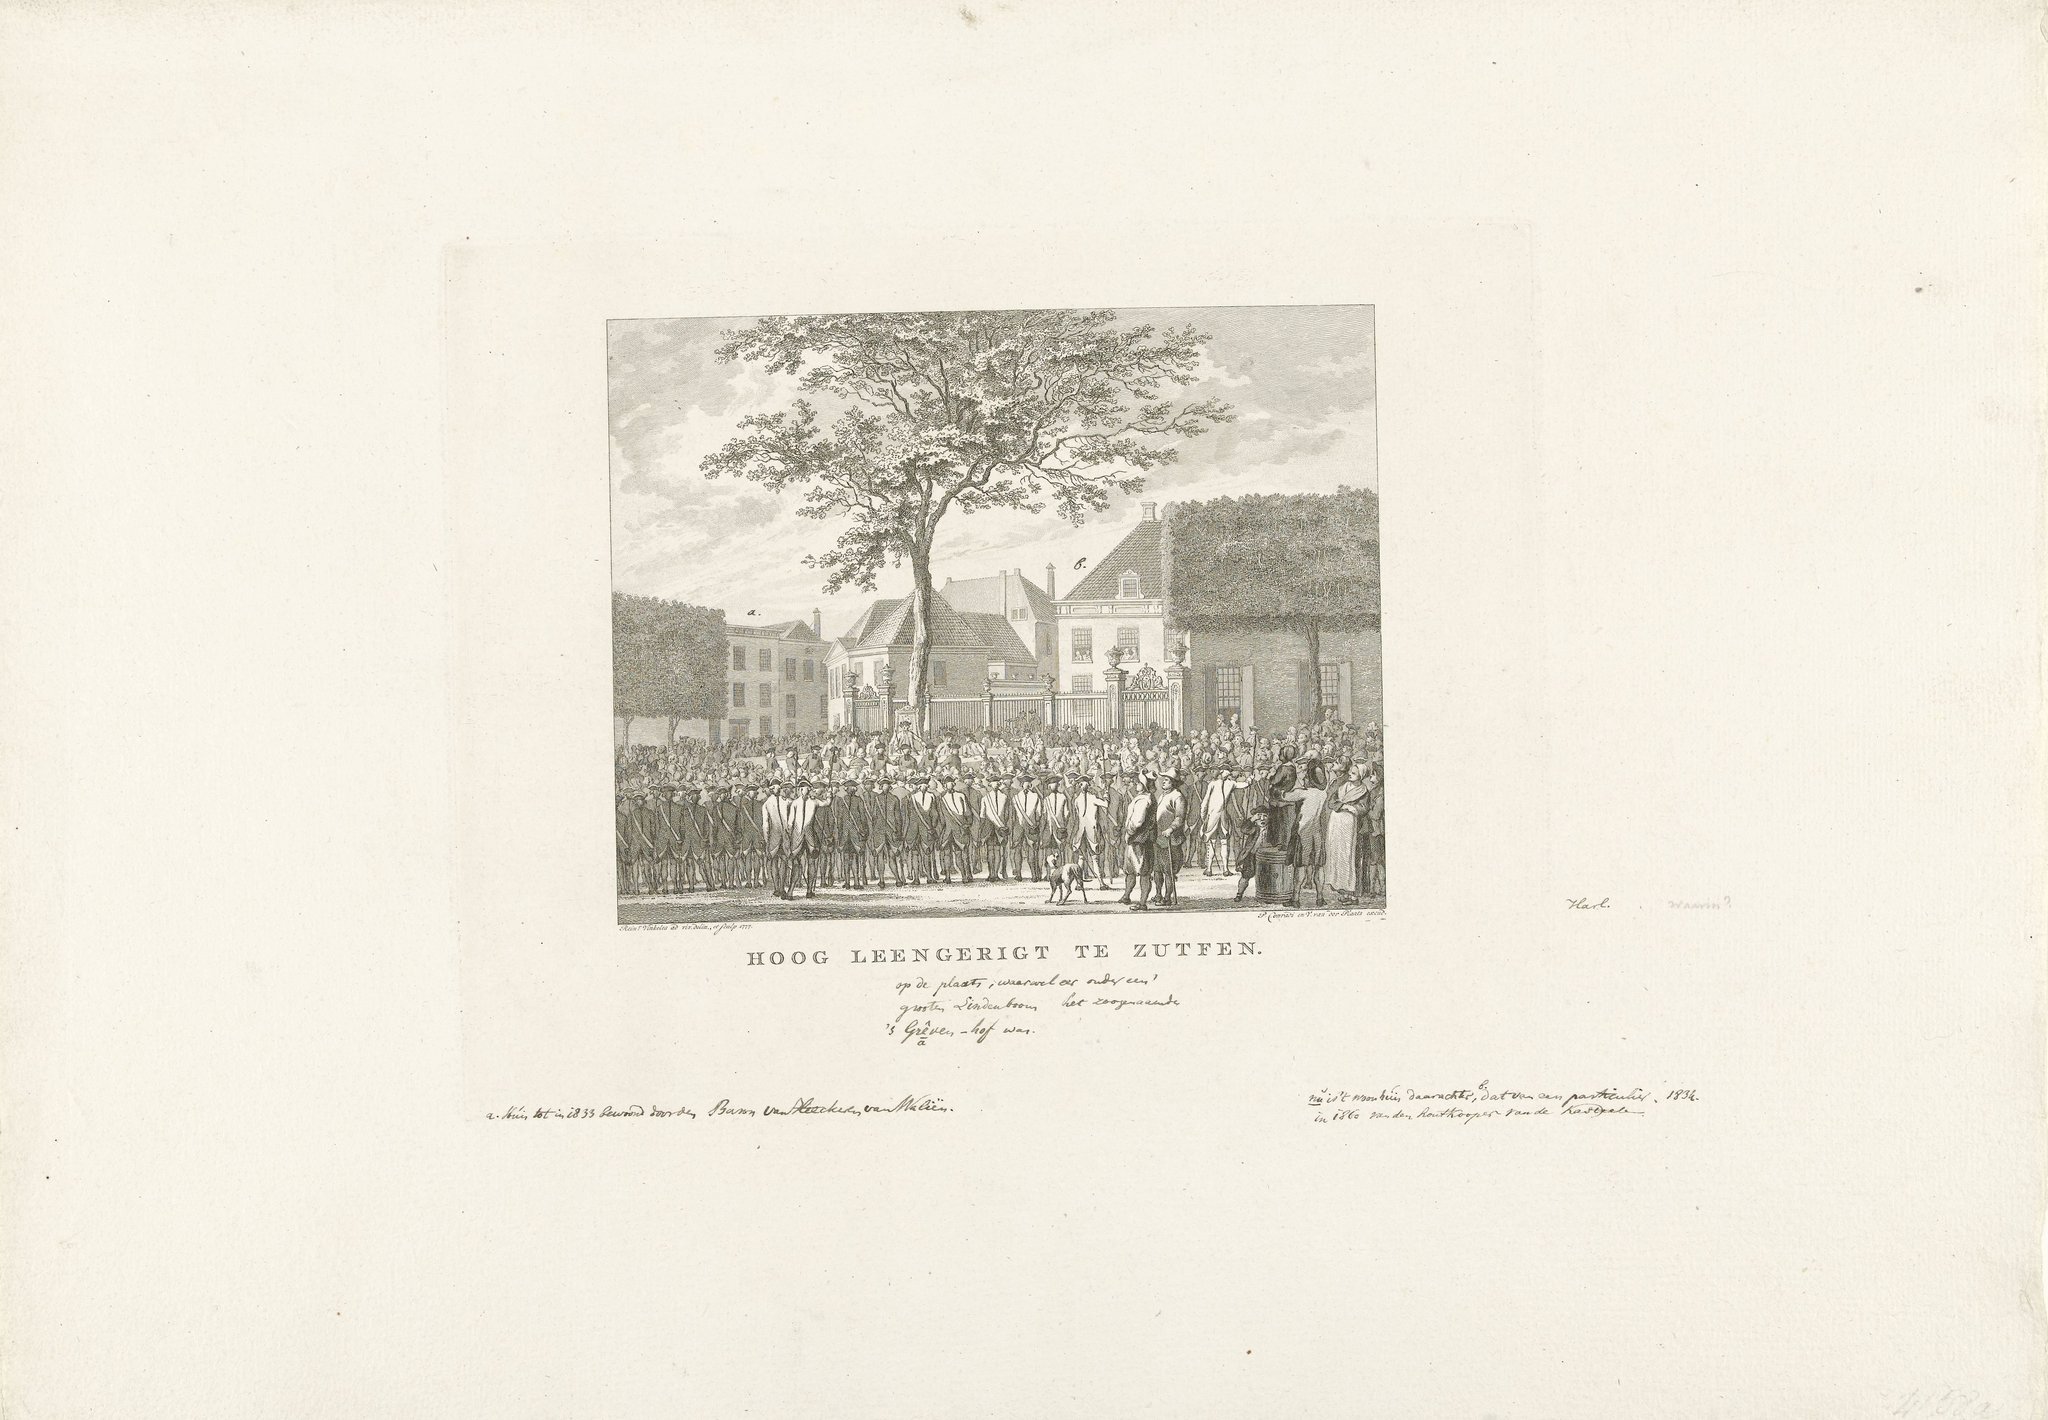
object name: print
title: Leengerecht te Zutphen, 1764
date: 1777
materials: paper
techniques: etching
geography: northern netherlands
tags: law and jurisprudence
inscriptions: collector's mark: Lugt 2228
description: Bijeenkomst van het leengerecht in de open lucht onder de eik, 17 oktober 1764. Te midden van het 's Gravenhof te Zutphen zitten leden van het gerechtshof voor leenzaken aan een tafel. Burgers en leden van de schutterij hebben zich rondom de met een omheining afgeschermde tafel opgesteld om deze bijeenkomst te kunnen volgen.